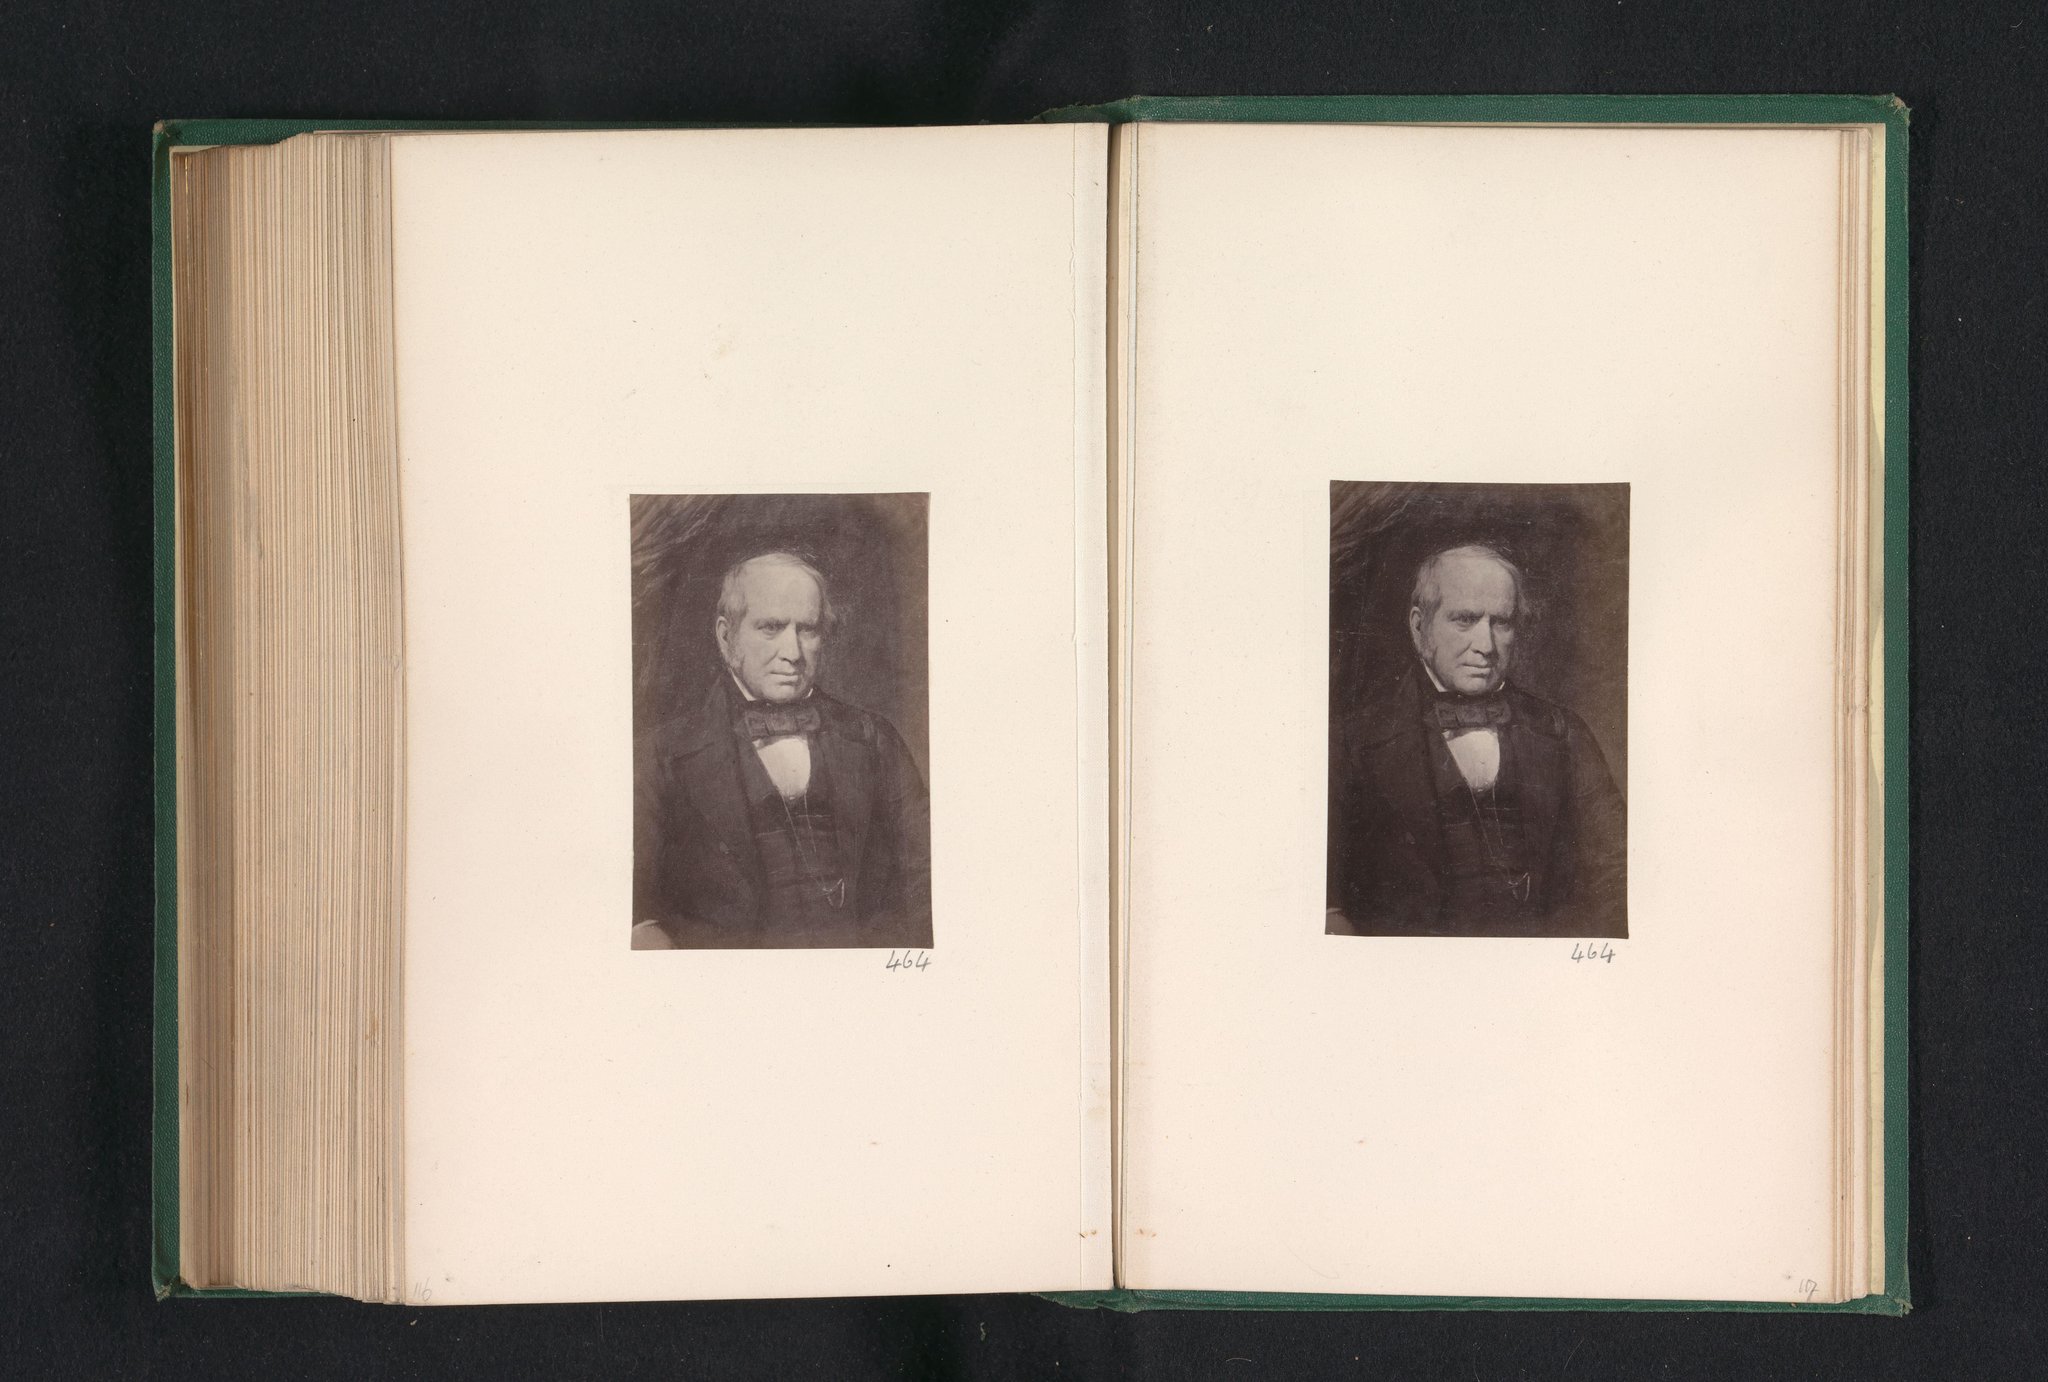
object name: page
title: Fotoreproductie van een schilderij, voorstellende een portret van een onbekende man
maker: thomas annan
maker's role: fotograaf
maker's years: 1829-1887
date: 1863-1868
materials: photographic support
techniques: albumen print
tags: historical persons (portraits and scenes from the life)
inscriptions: number: ‘464’